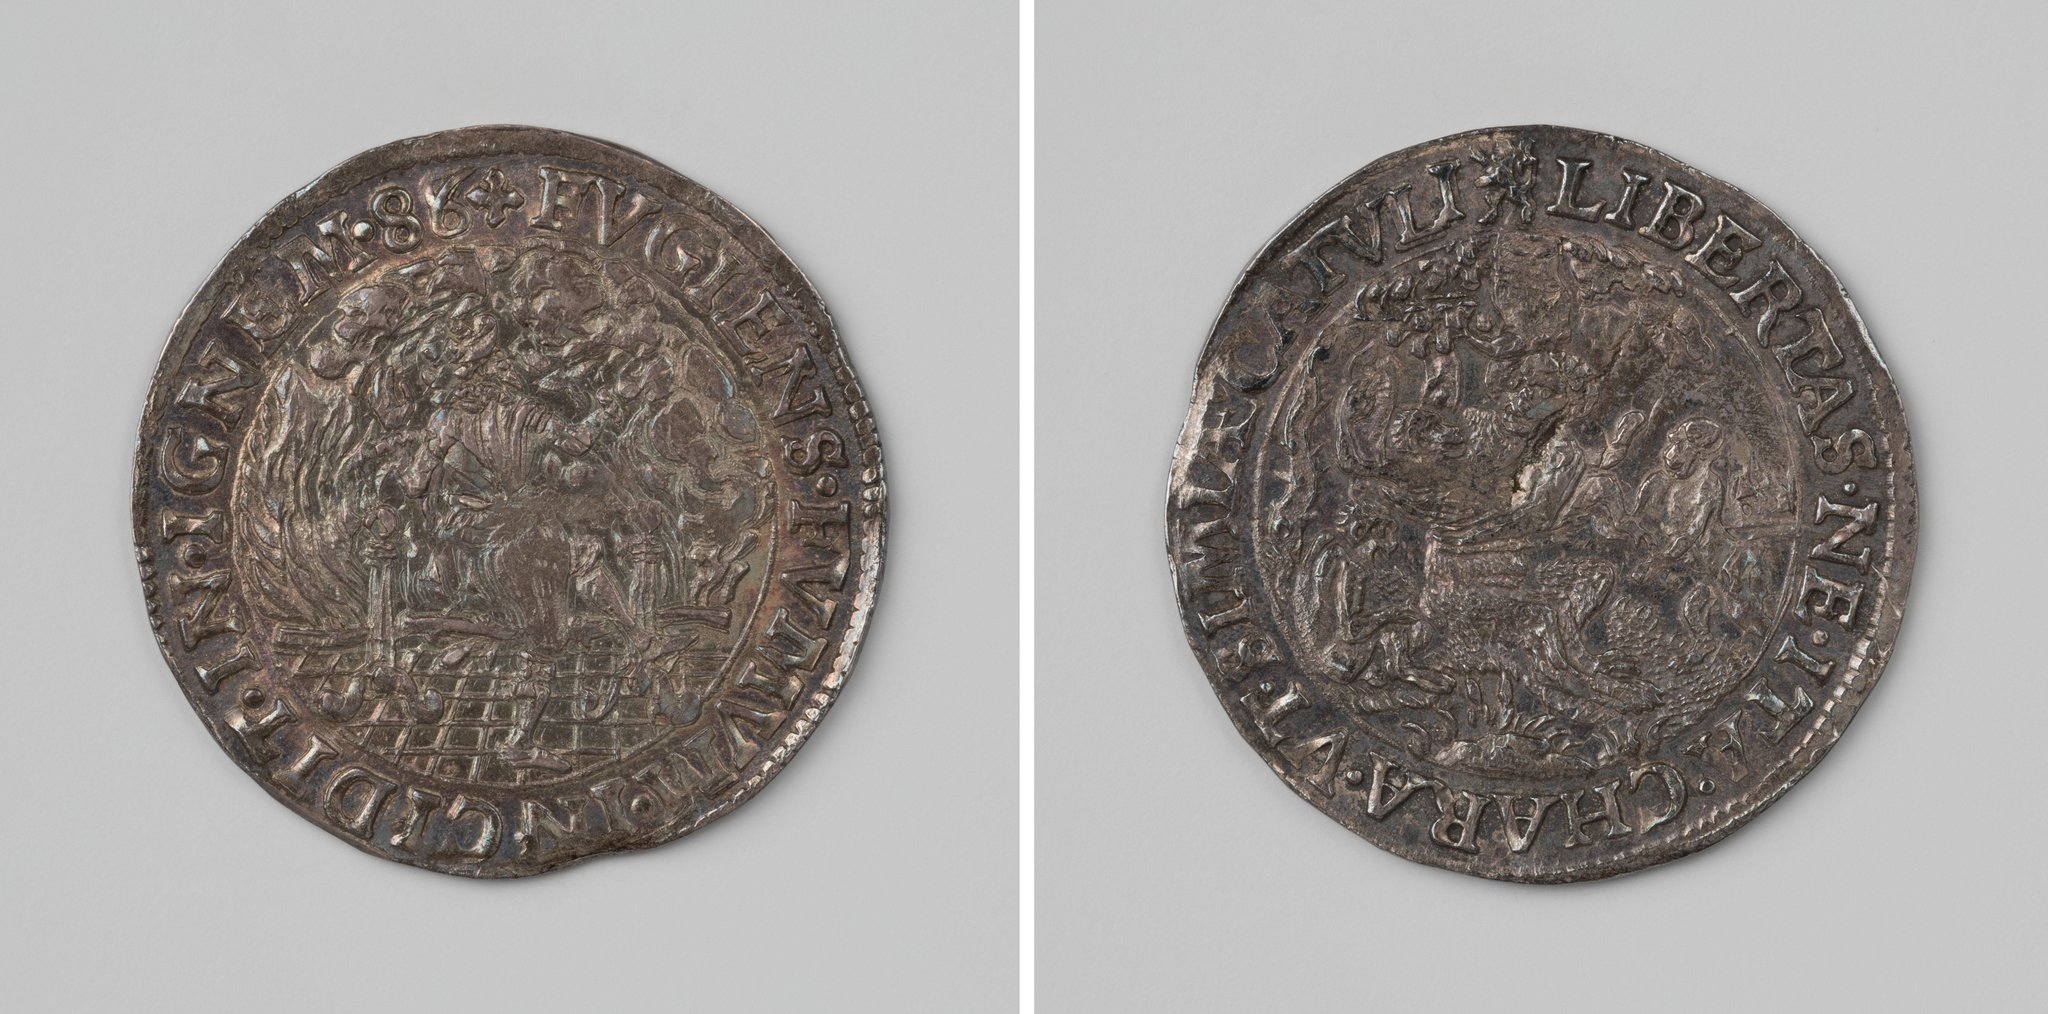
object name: jeton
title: Allegorische waarschuwing voor de onbetrouwbaarheid der Engelse bondgenoten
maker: Anonymous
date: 1586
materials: silver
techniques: striking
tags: tachtigjarige oorlog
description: Zilveren penning. Voorzijde: man, die rook ontvlucht en in vuur terecht komt binnen omschrift. Keerzijde: aap met jongen binnen omschrift